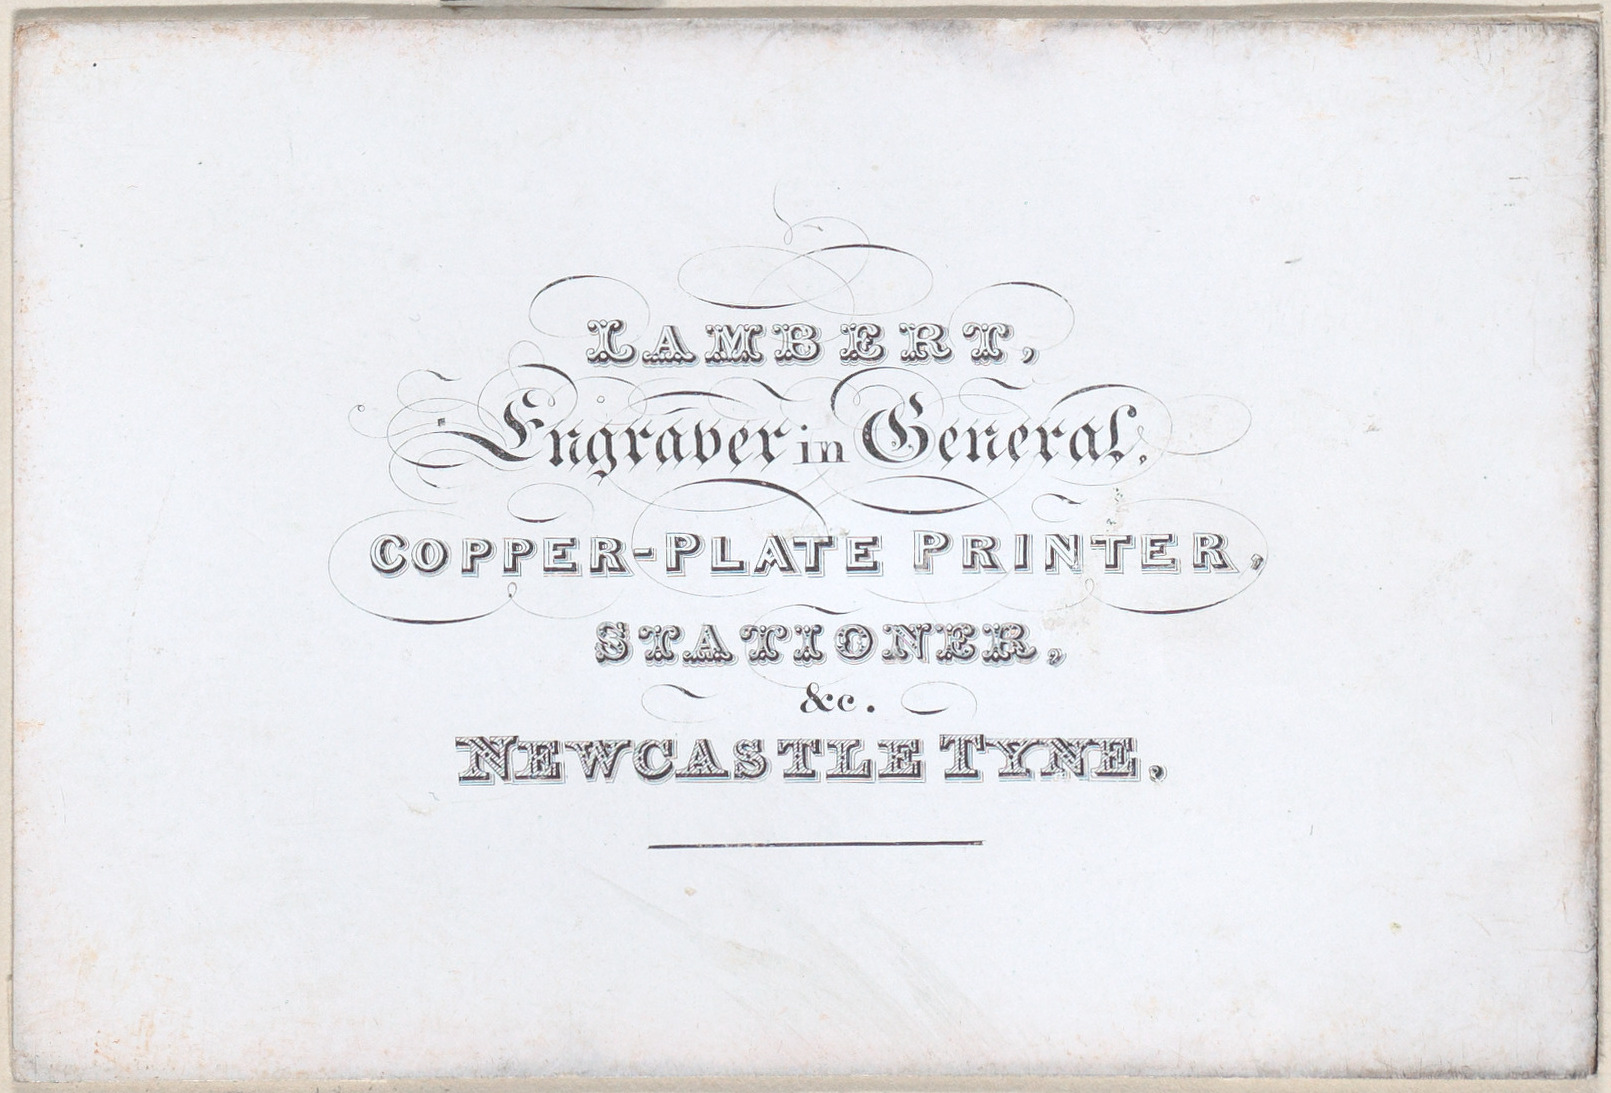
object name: print, trade card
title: Trade Card for Lambert, Engraver, Copper-Plate Printer, and Stationer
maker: anonymous, british, 18th century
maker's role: artist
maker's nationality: british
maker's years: 1700-1800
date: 1701-1800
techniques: engraving